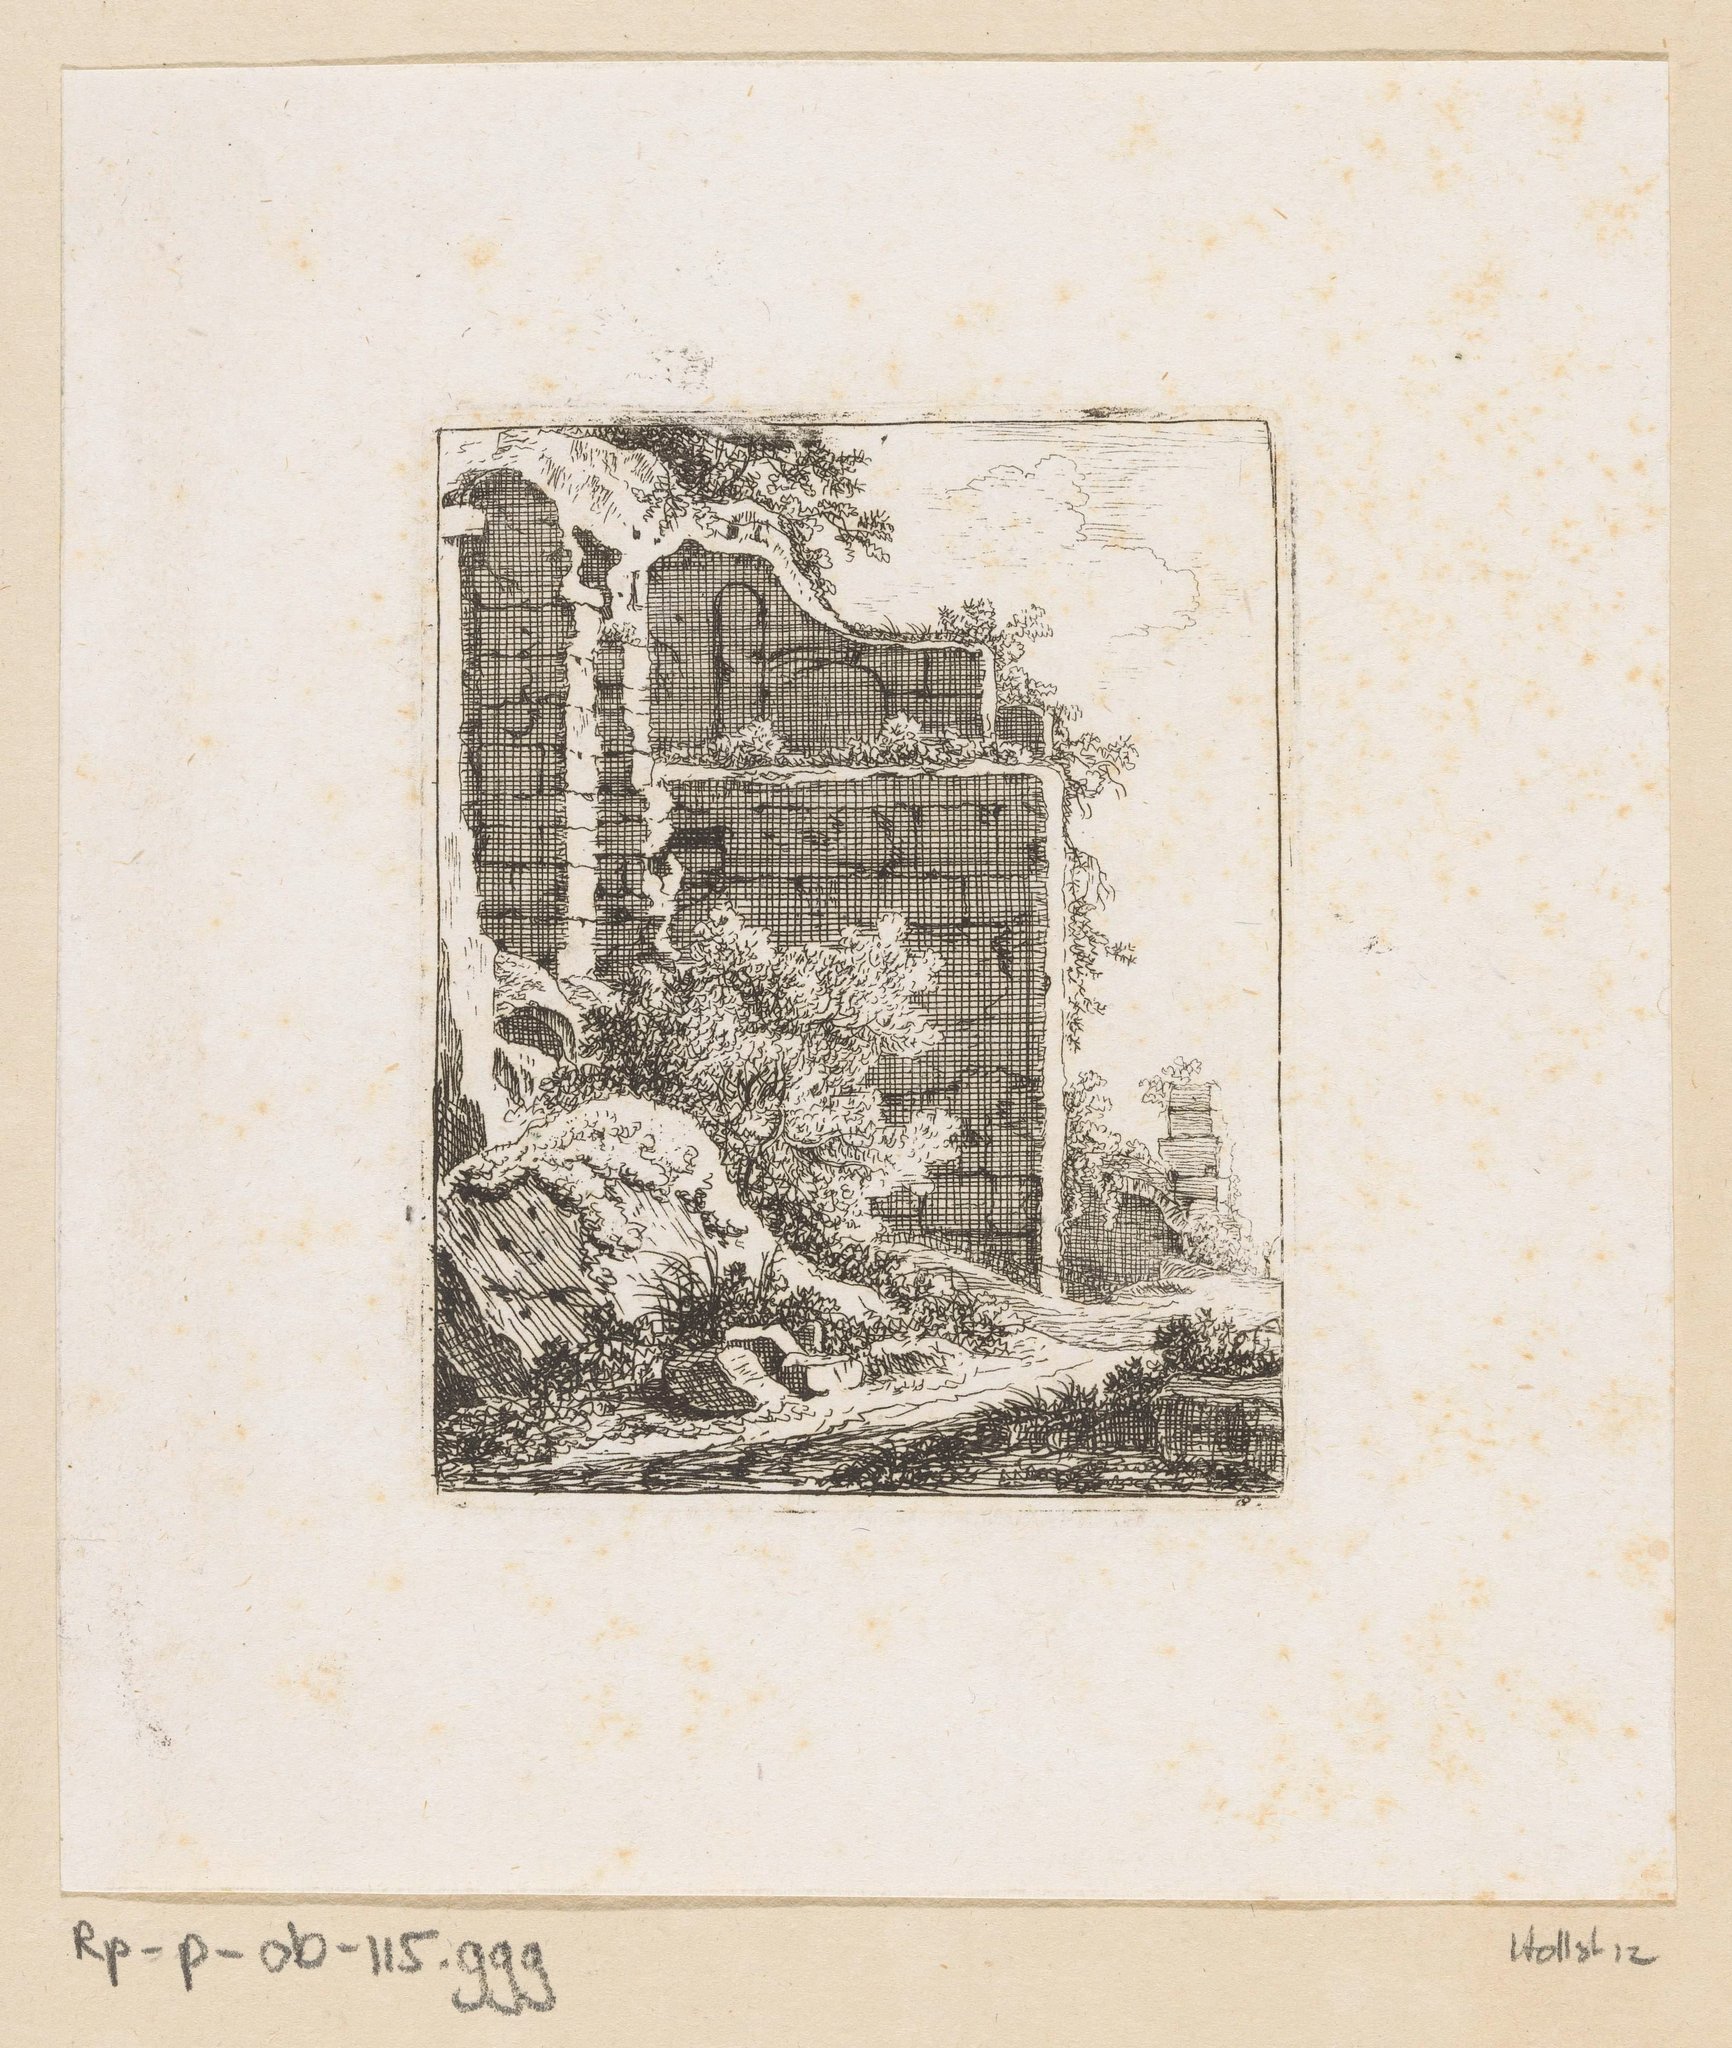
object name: print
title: Romeinse ruïnes en monumenten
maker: johann franz ermels (der ältere)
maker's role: draughtsman, print maker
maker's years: 1641-1693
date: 1651-1693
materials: paper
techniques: etching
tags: fence, wall, paling, landscape with ruins, rome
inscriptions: collector's mark: Lugt 240